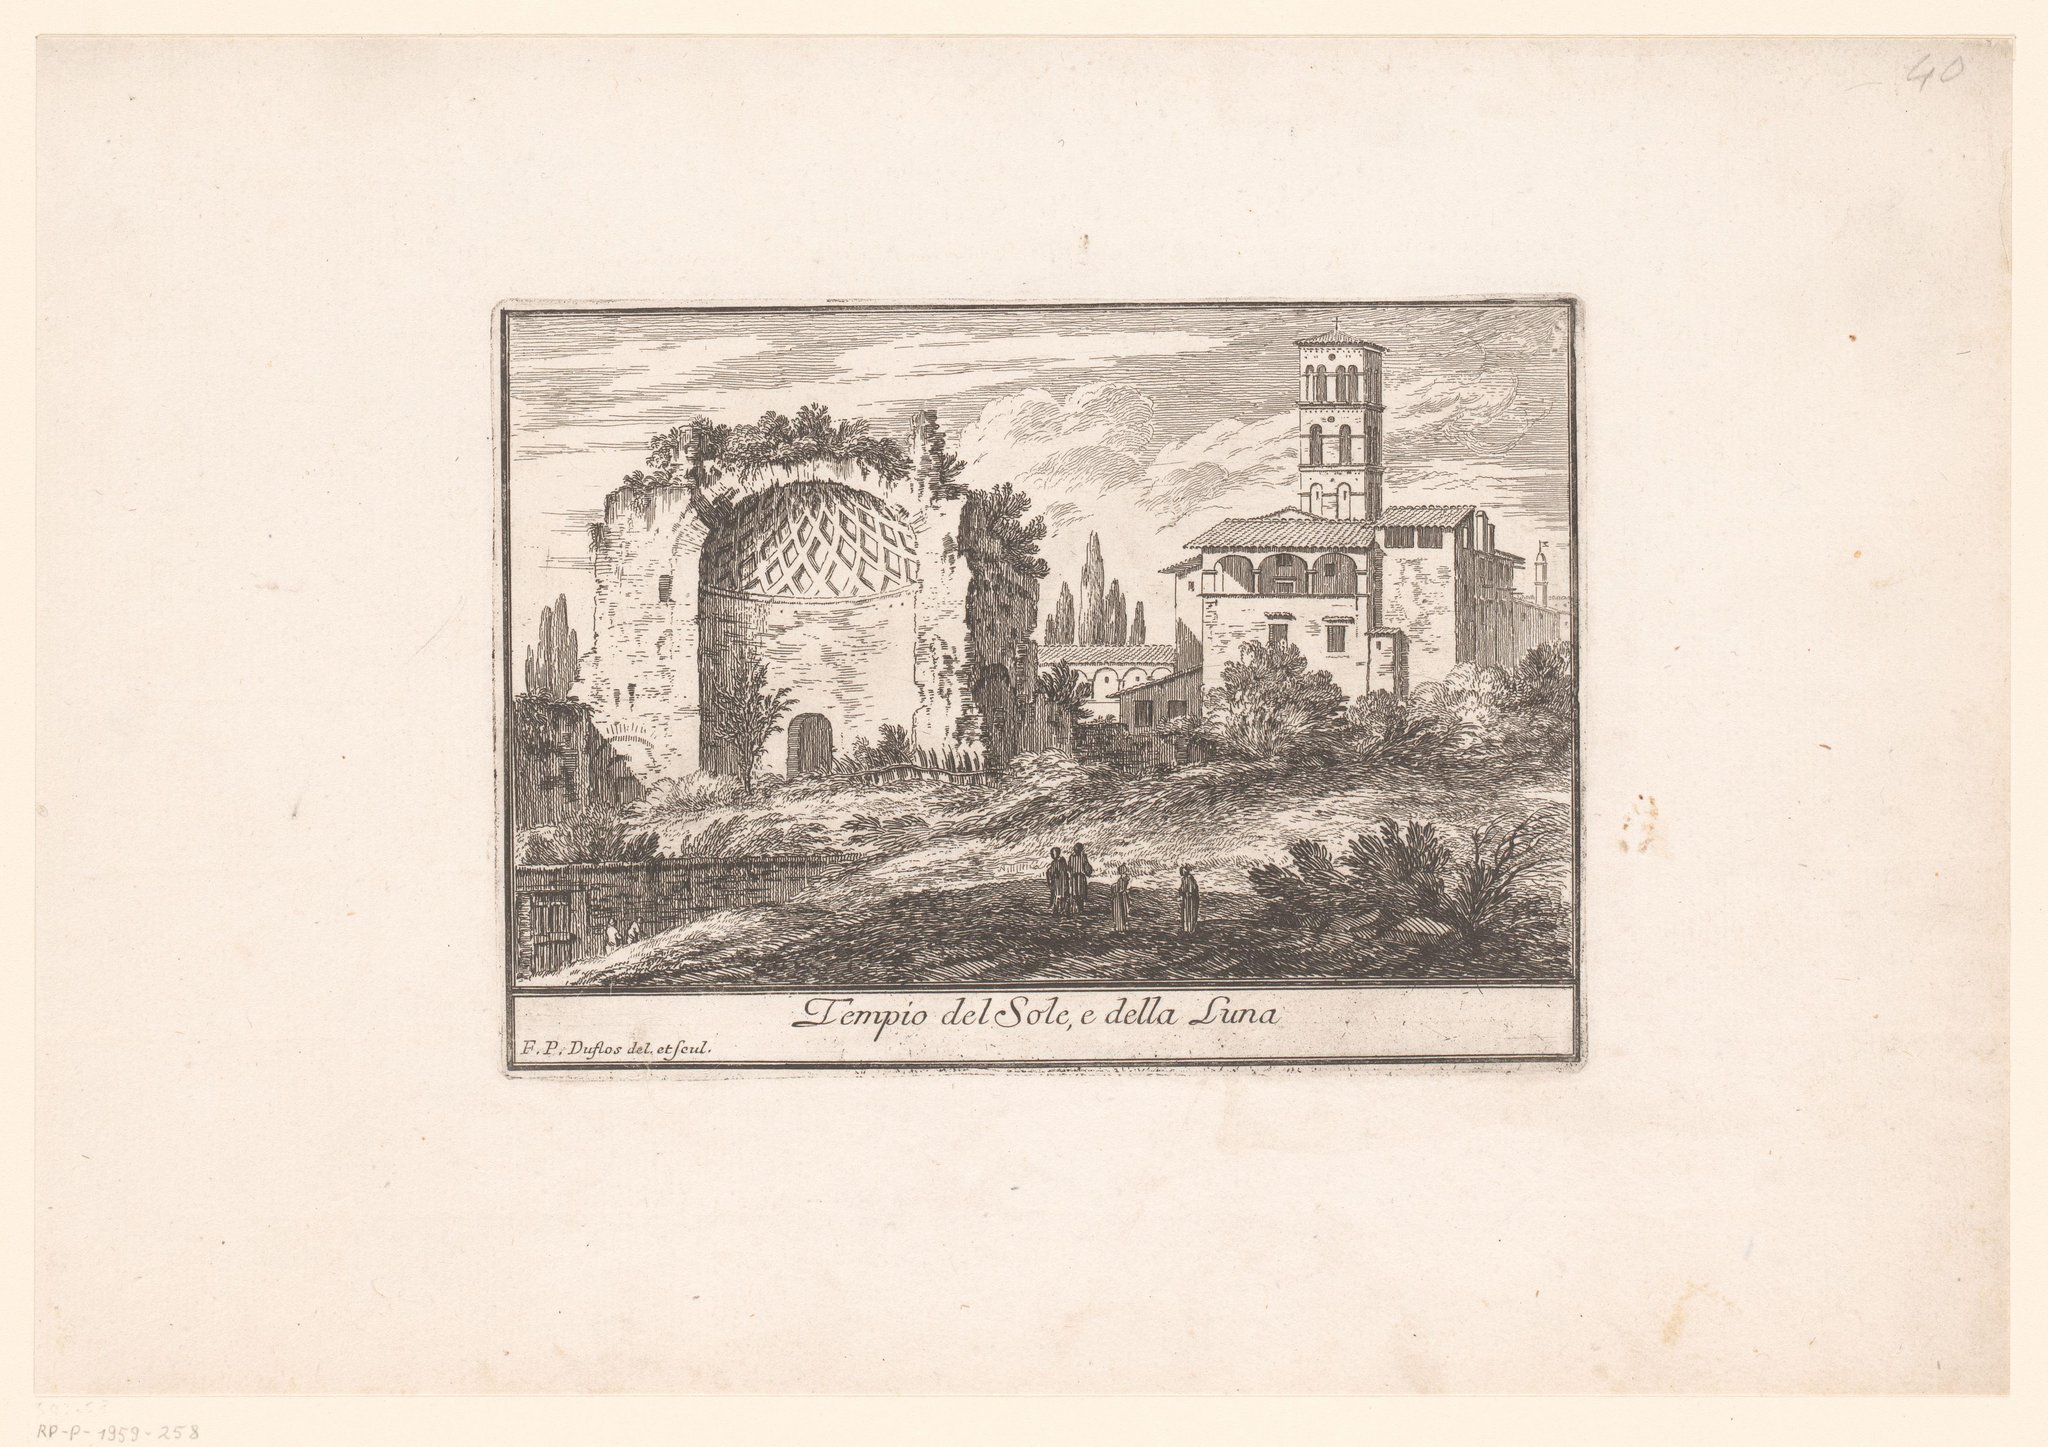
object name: print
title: Zicht op de Tempel van de Zon en de Maan in Rome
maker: philothée françois duflos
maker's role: print maker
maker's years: 1710-1748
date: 1748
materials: paper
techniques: etching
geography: france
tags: church (exterior)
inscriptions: collector's mark: Lugt 2760, collector's mark: Lugt 2228